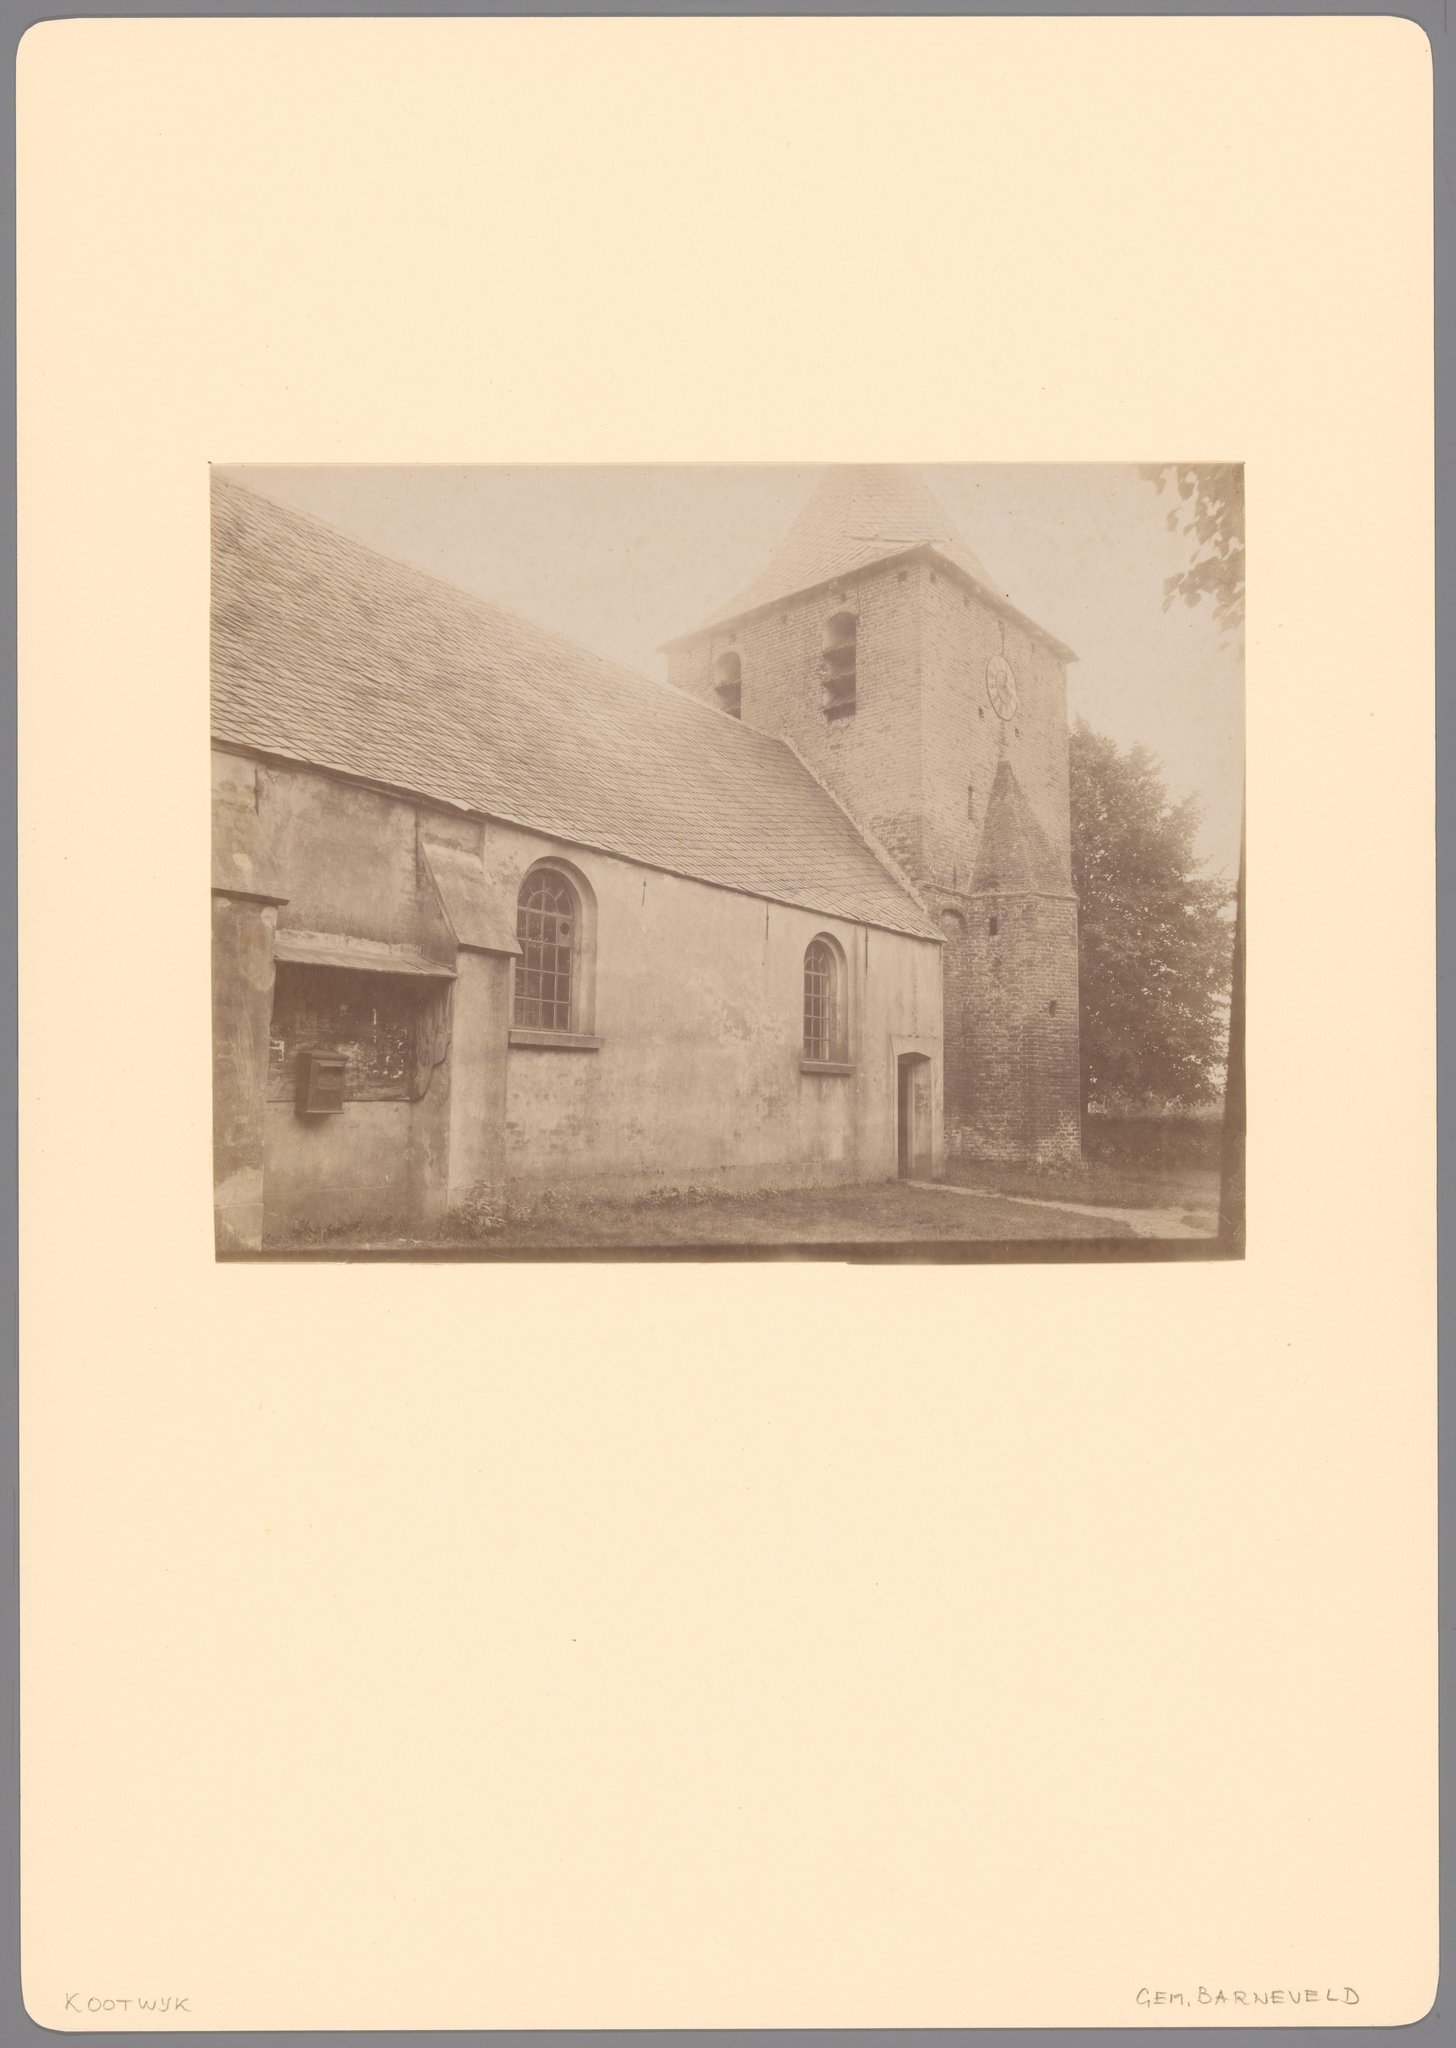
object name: photograph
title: Gezicht op de Hervormde Kerk te Kootwijk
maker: anoniem (monumentenzorg)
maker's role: fotograaf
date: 1903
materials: cardboard, photographic support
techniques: albumen print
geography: kootwijk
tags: church (exterior)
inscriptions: annotation: ‘Kootwijk/ gem. Barneveld’, annotation: ‘Kootwijk veluwe (G.)/ Kerk der N.H. Kerk’